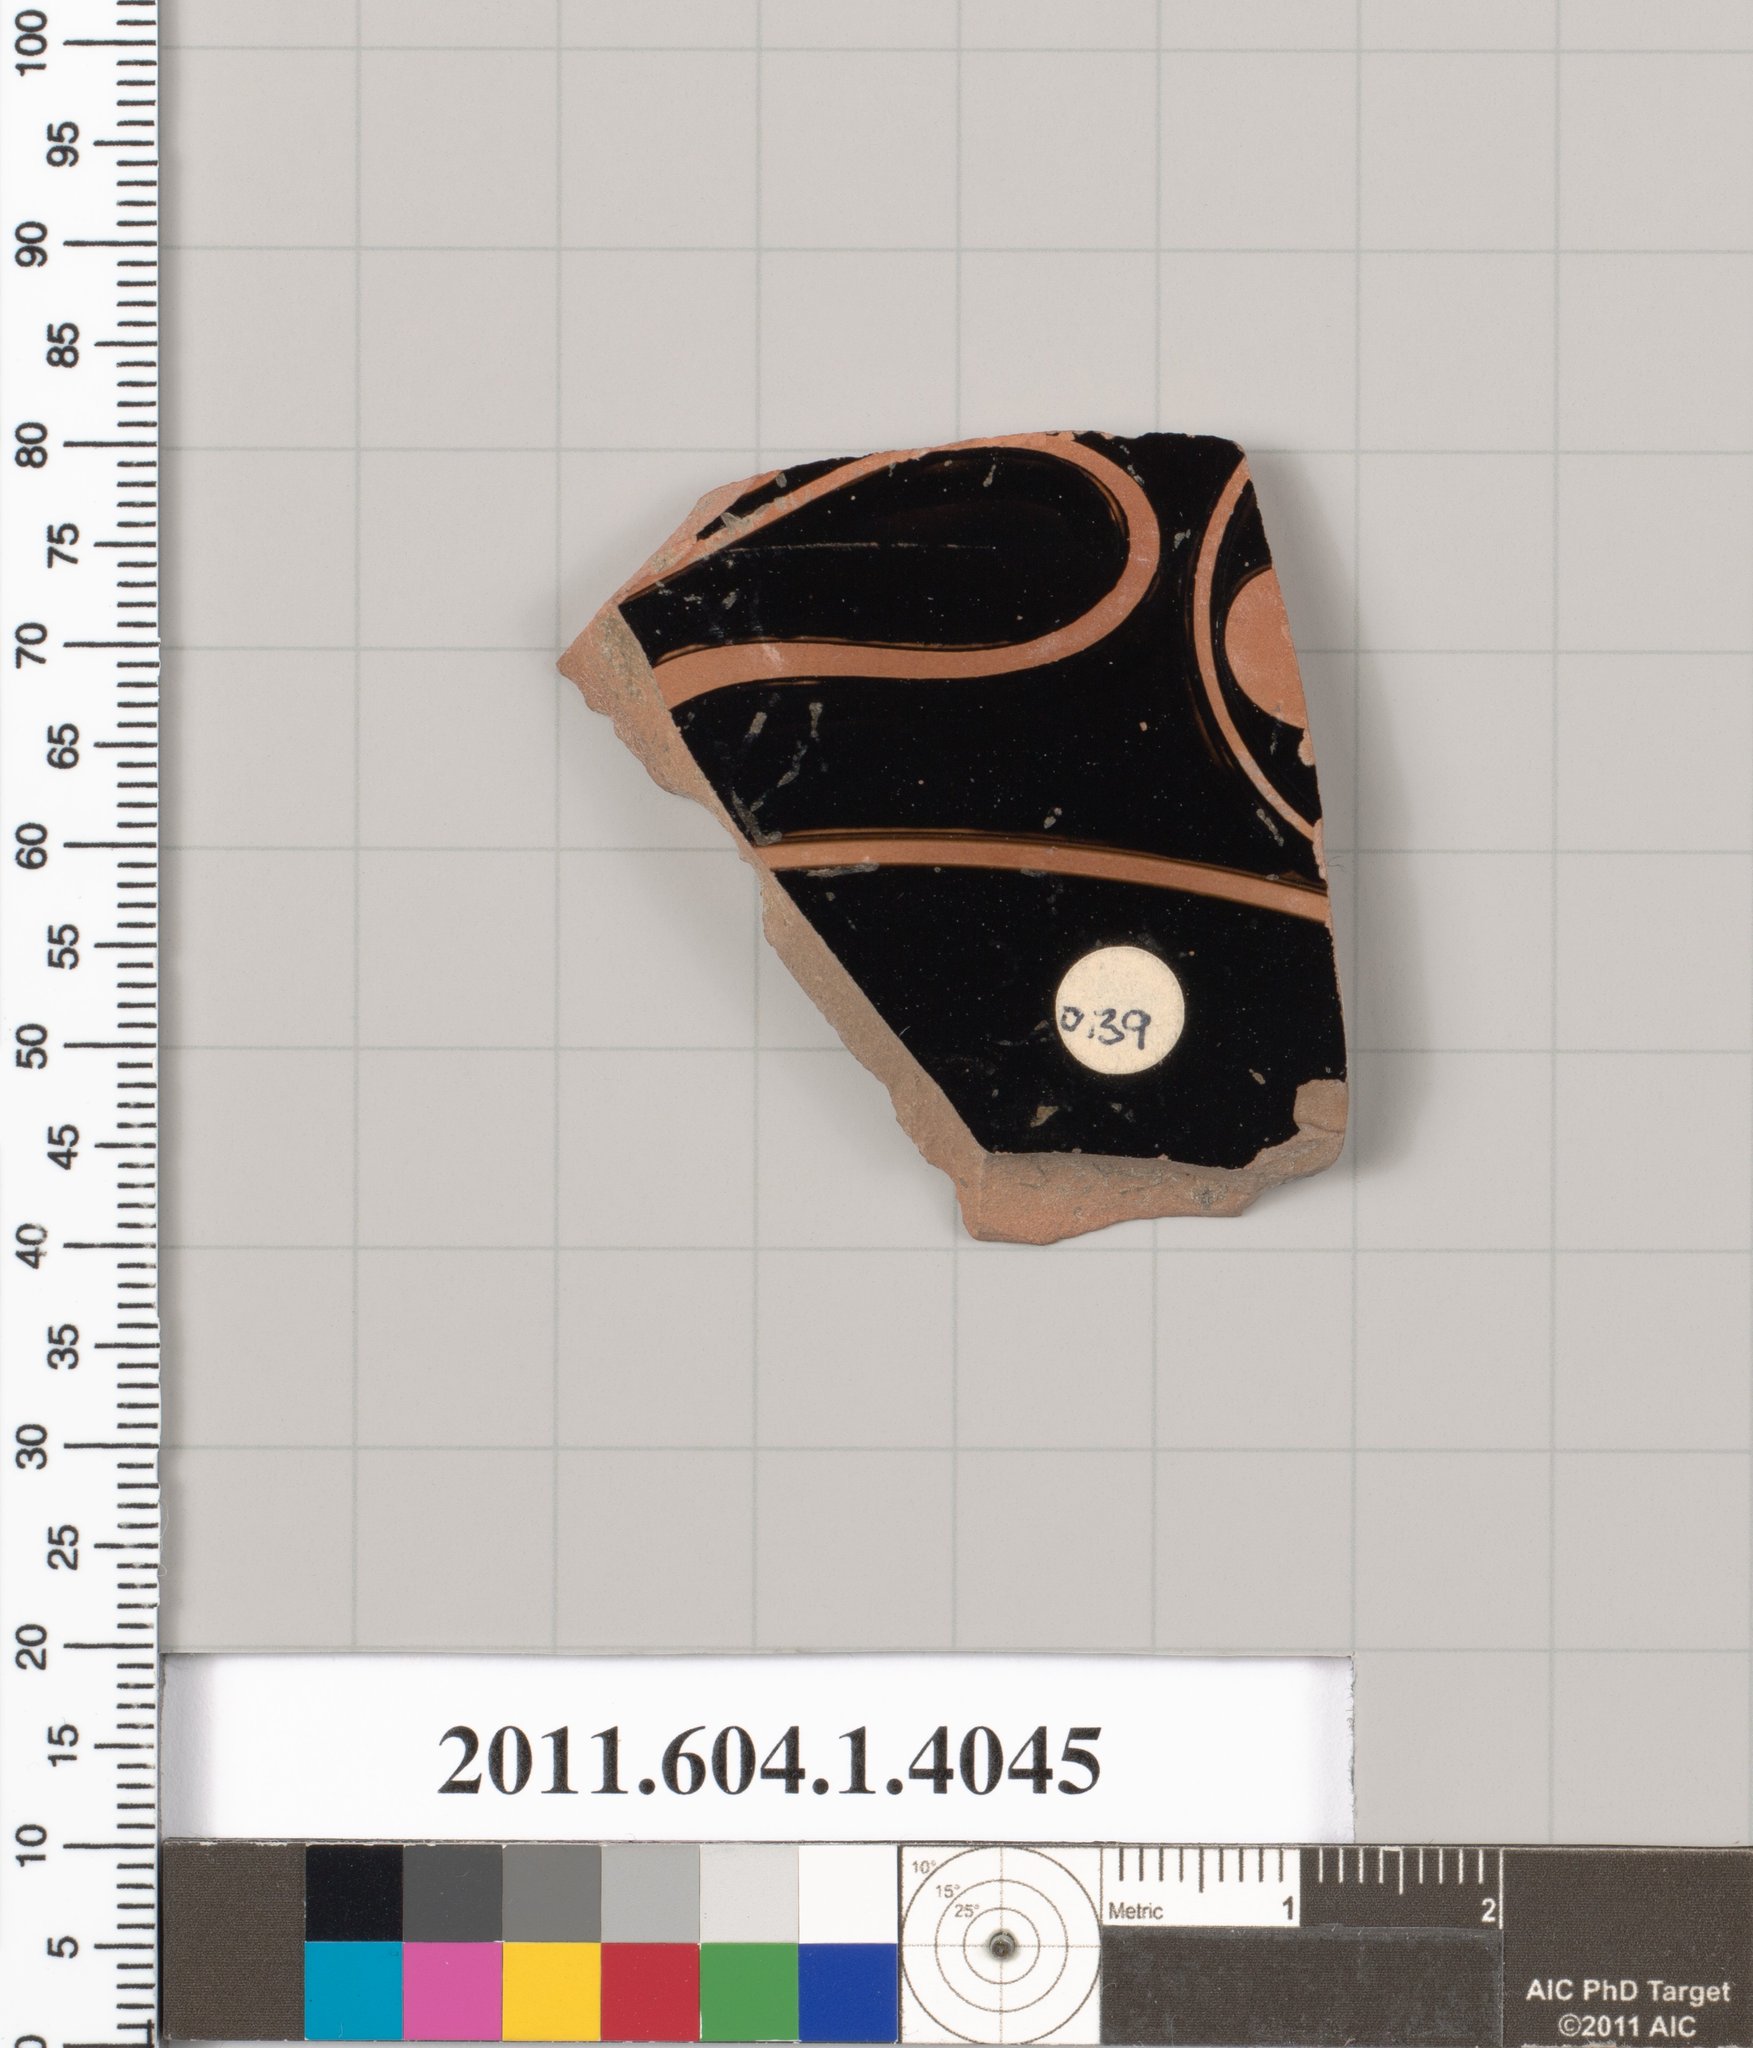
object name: kylix fragment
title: Terracotta fragment of a kylix (drinking cup)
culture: greek, attic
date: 534-468 BCE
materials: terracotta